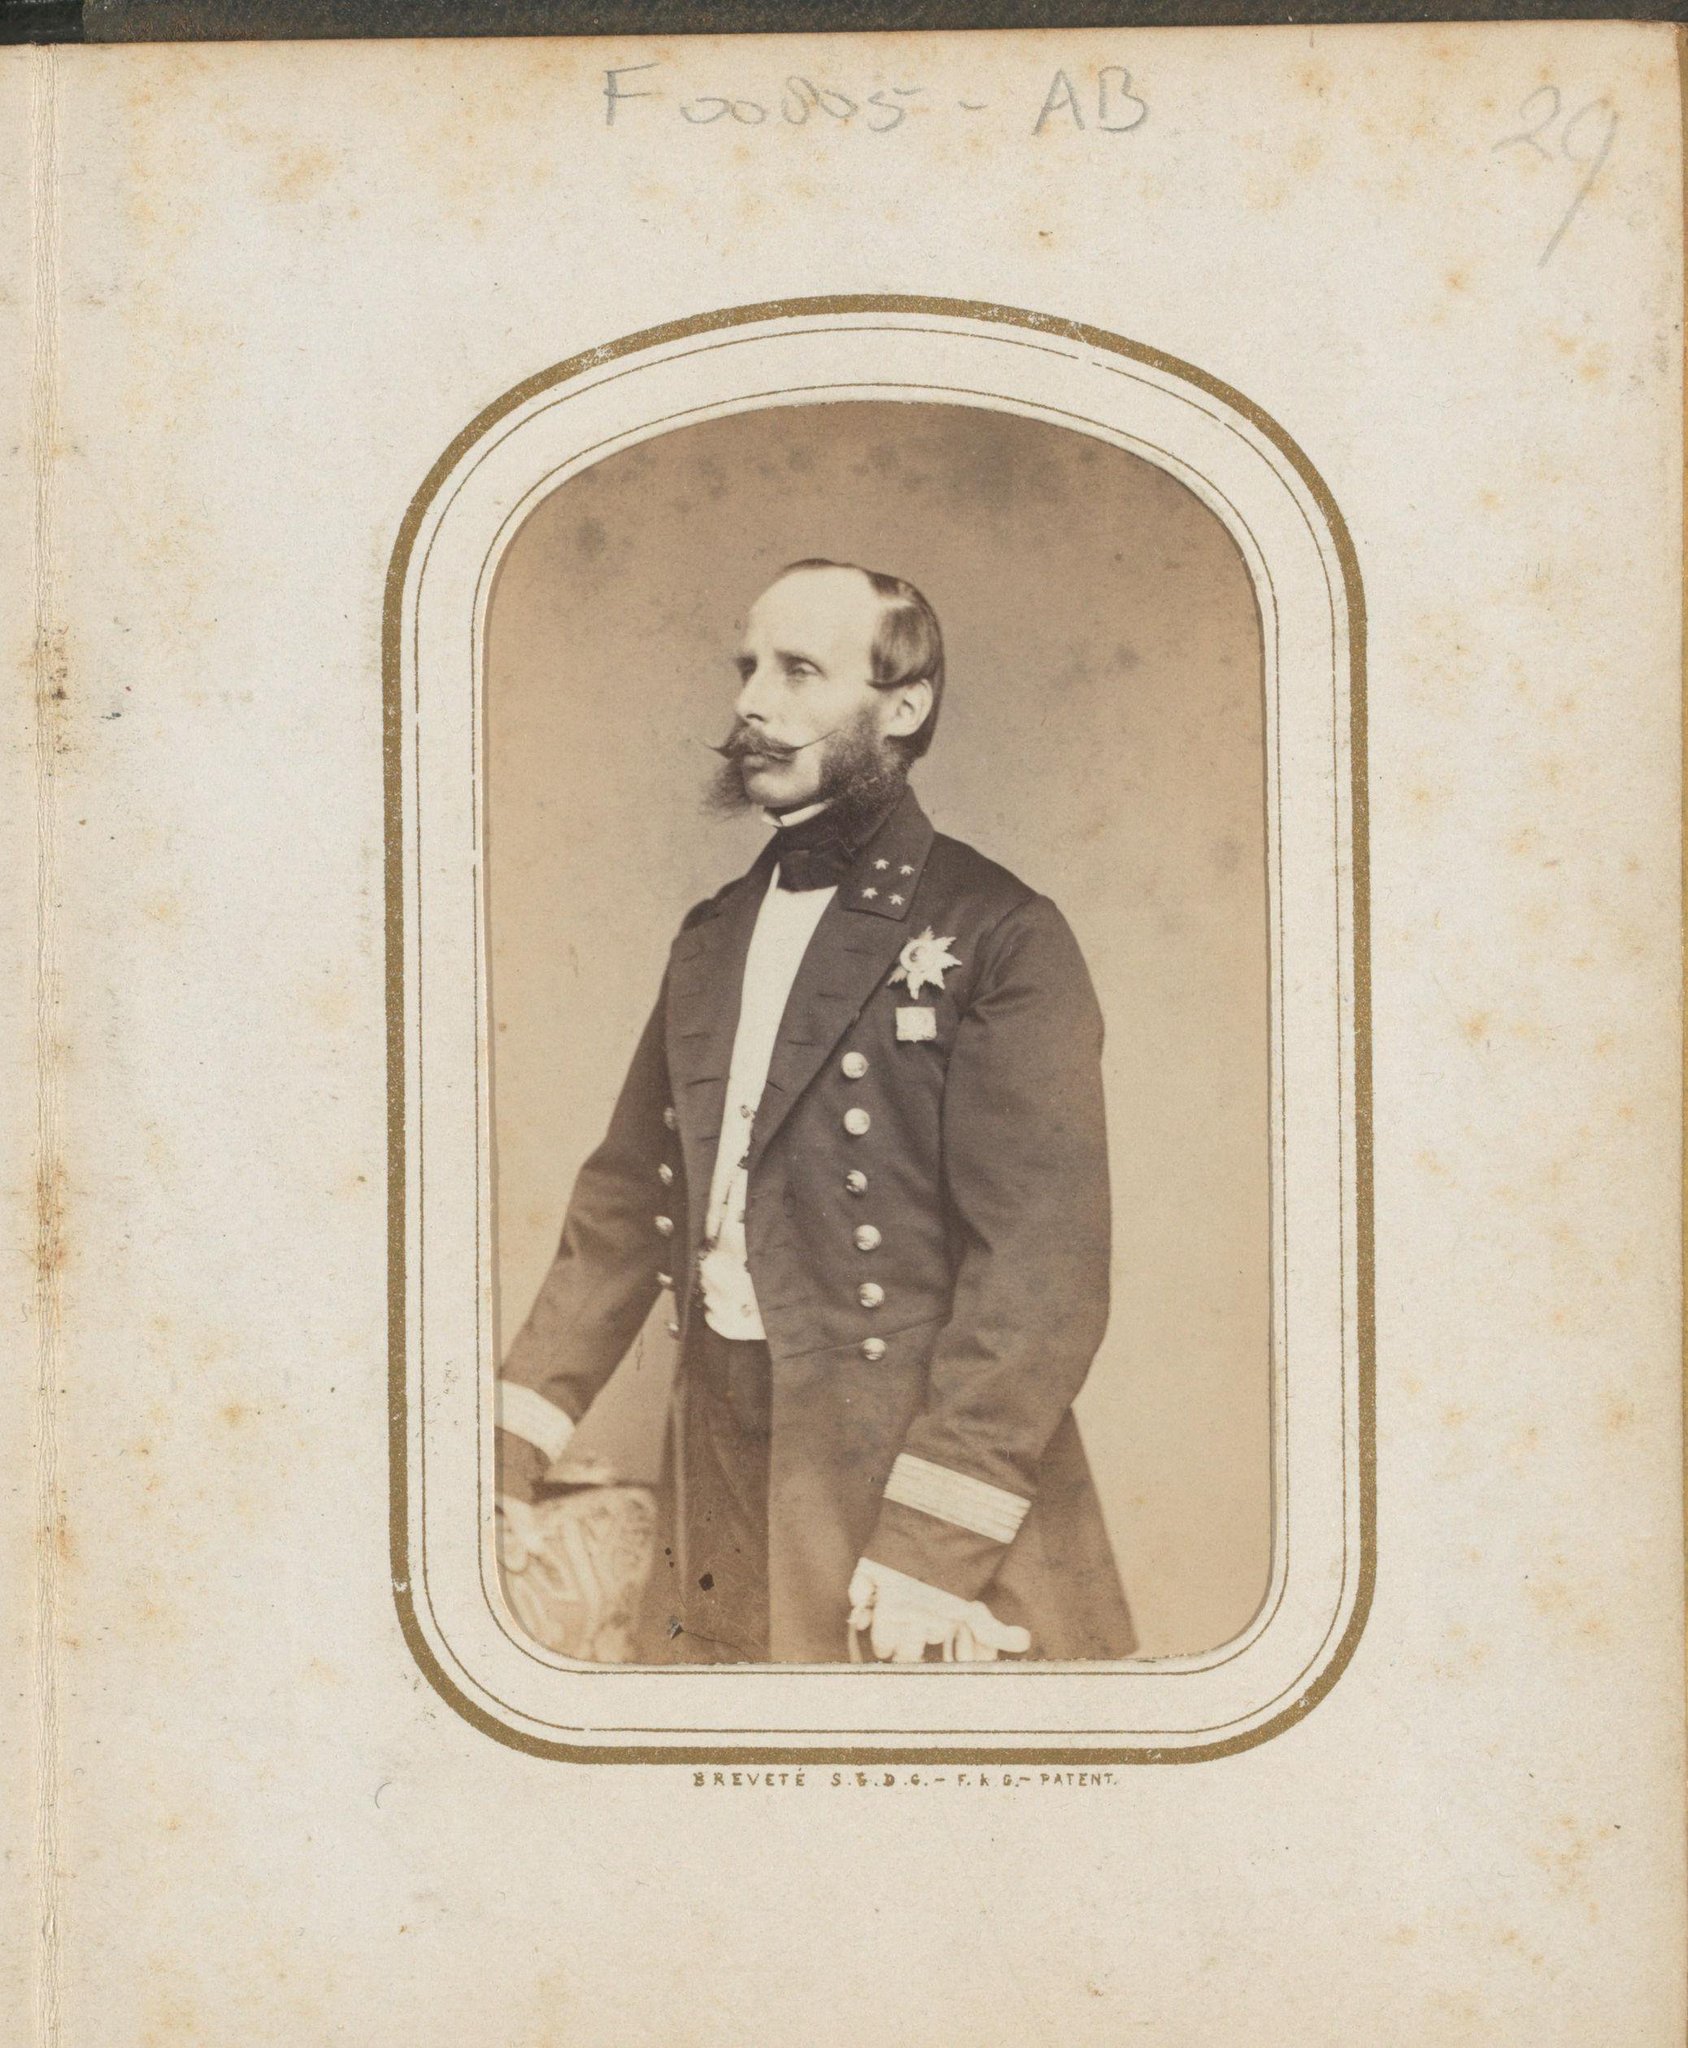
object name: carte de visite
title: Portret van prins Hendrik, broer van koning Willem III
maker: johann schäfer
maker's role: fotograaf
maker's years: 1822-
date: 1860-1879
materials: cardboard, paper, photographic support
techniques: albumen print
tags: hendrik (prins der nederlanden), sideburns, studio requisites ~ photographer, moustache, prince, historical persons, neck-gear ~ clothing, hairdress, decorations, honours (as symbols of the state, etc.), coat, cape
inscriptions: inscription: ‘Prinz Heinrich der Niederlande’, address: ‘Frankfurt a. M., Hochstrasse 34’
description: Onderdeel van Fotoalbum met 29 foto's van Nederlandse vorsten.